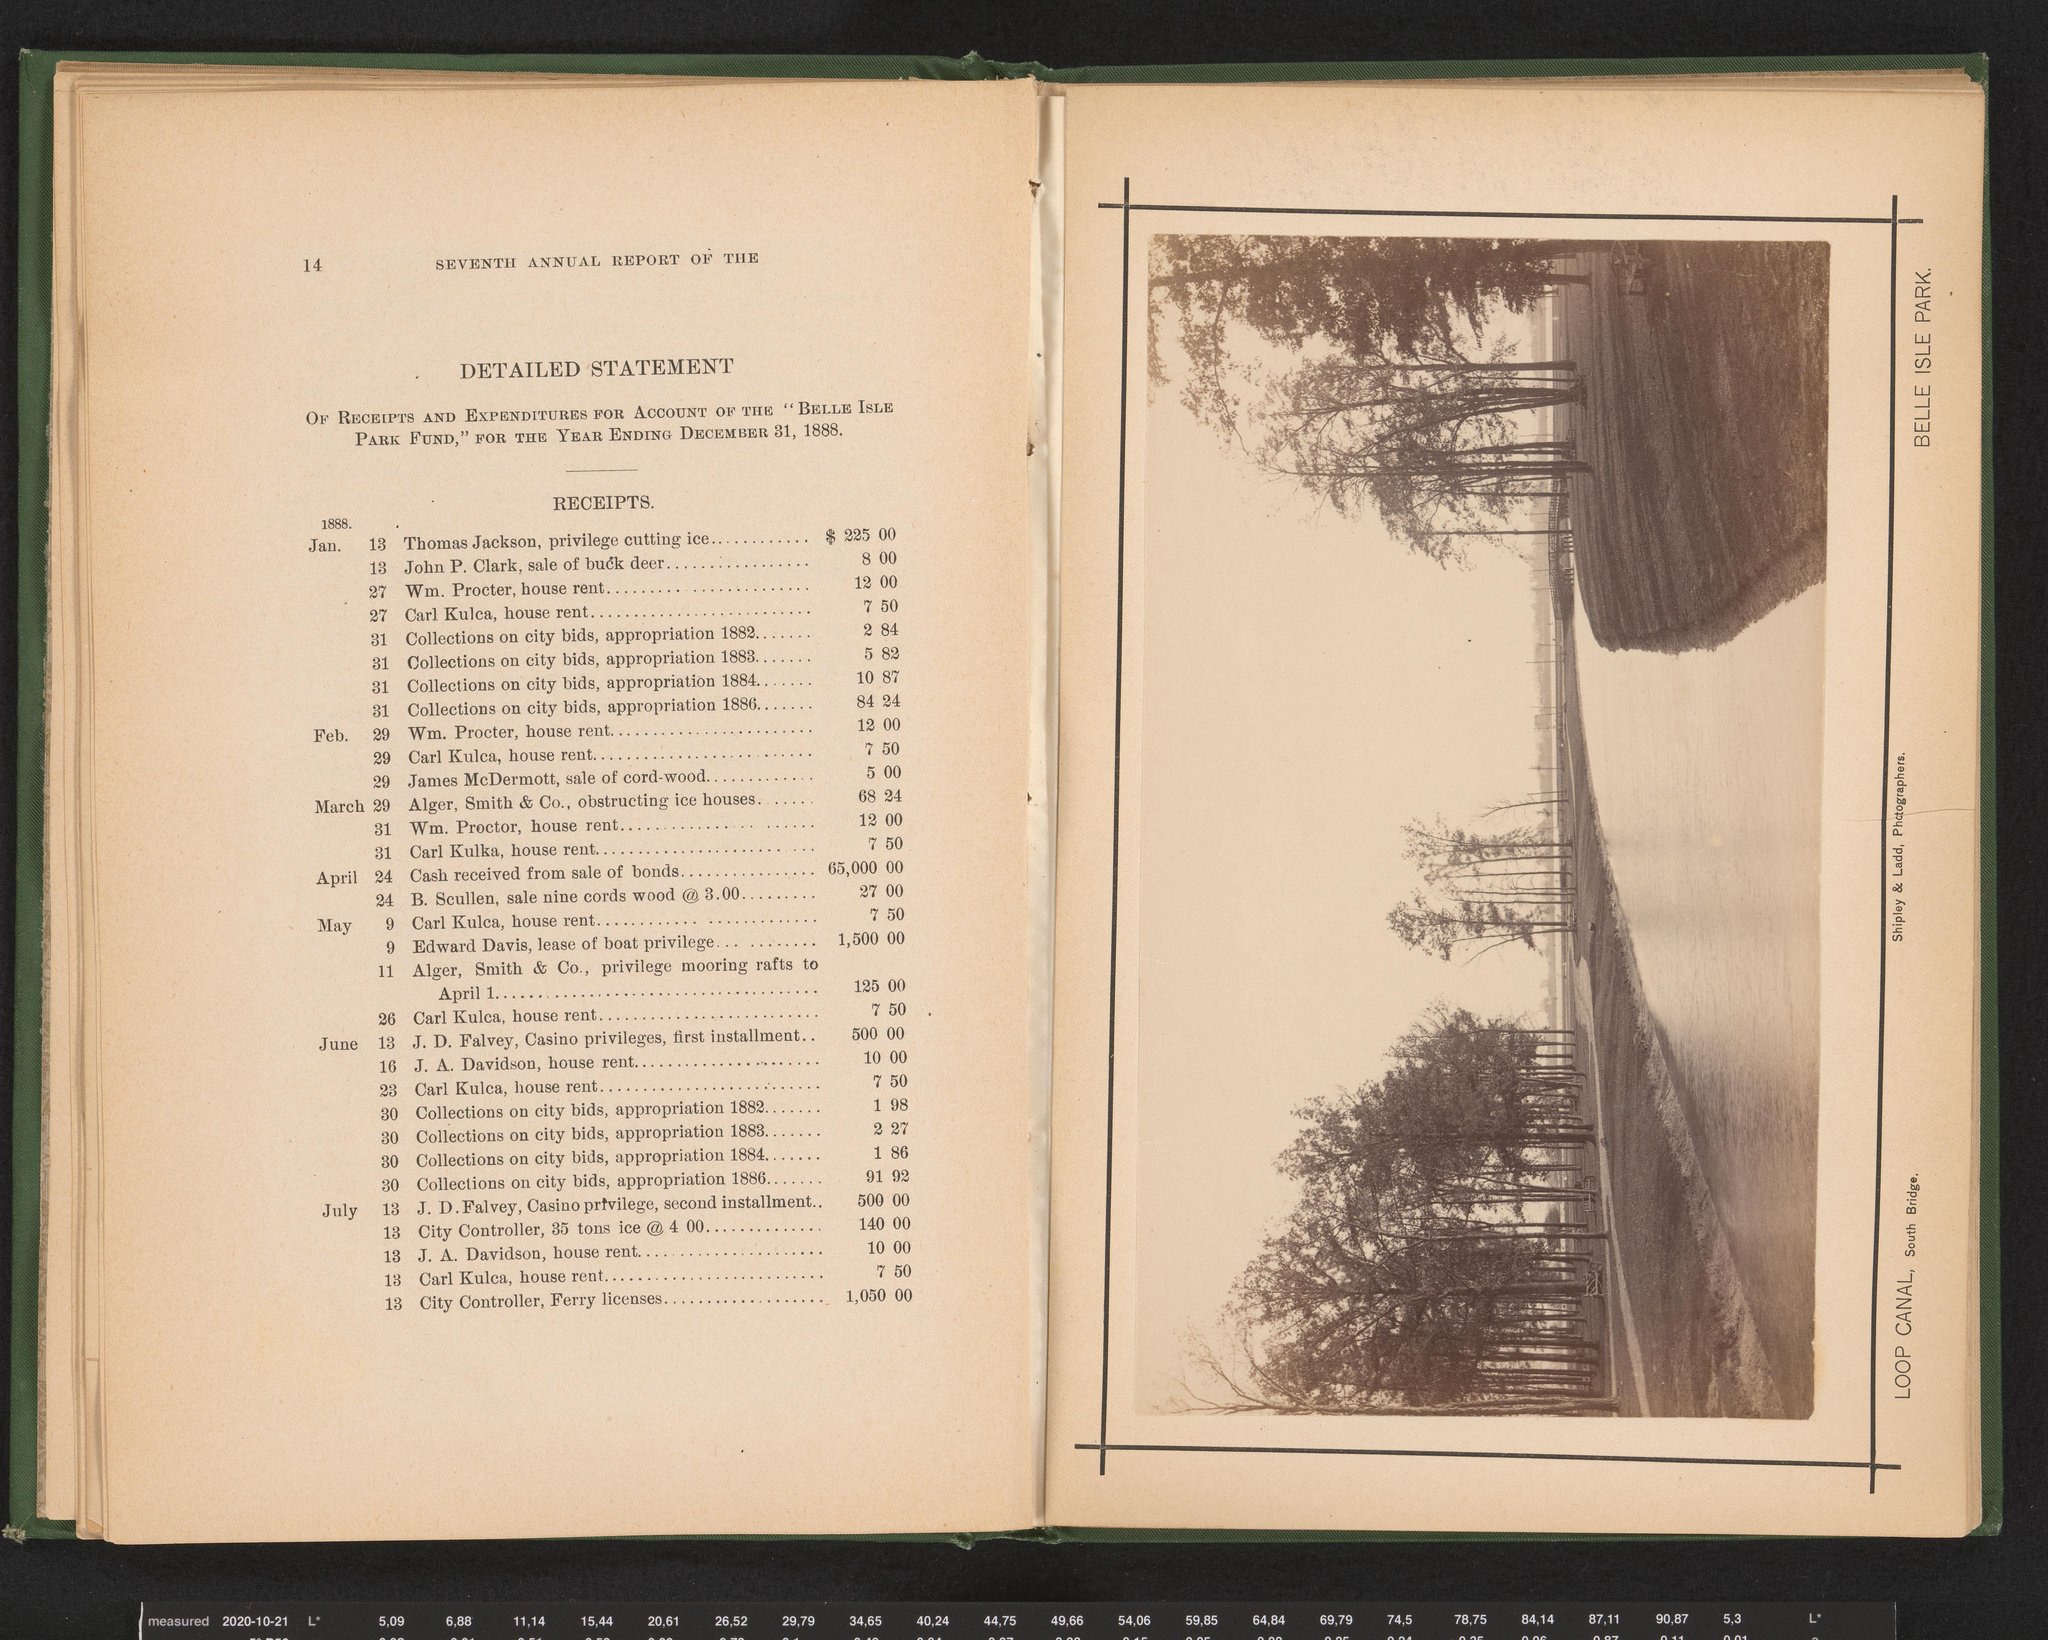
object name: photograph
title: Belle Isle Park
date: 1879-1889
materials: photographic support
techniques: albumen print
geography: belle isle park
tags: canal, bridge